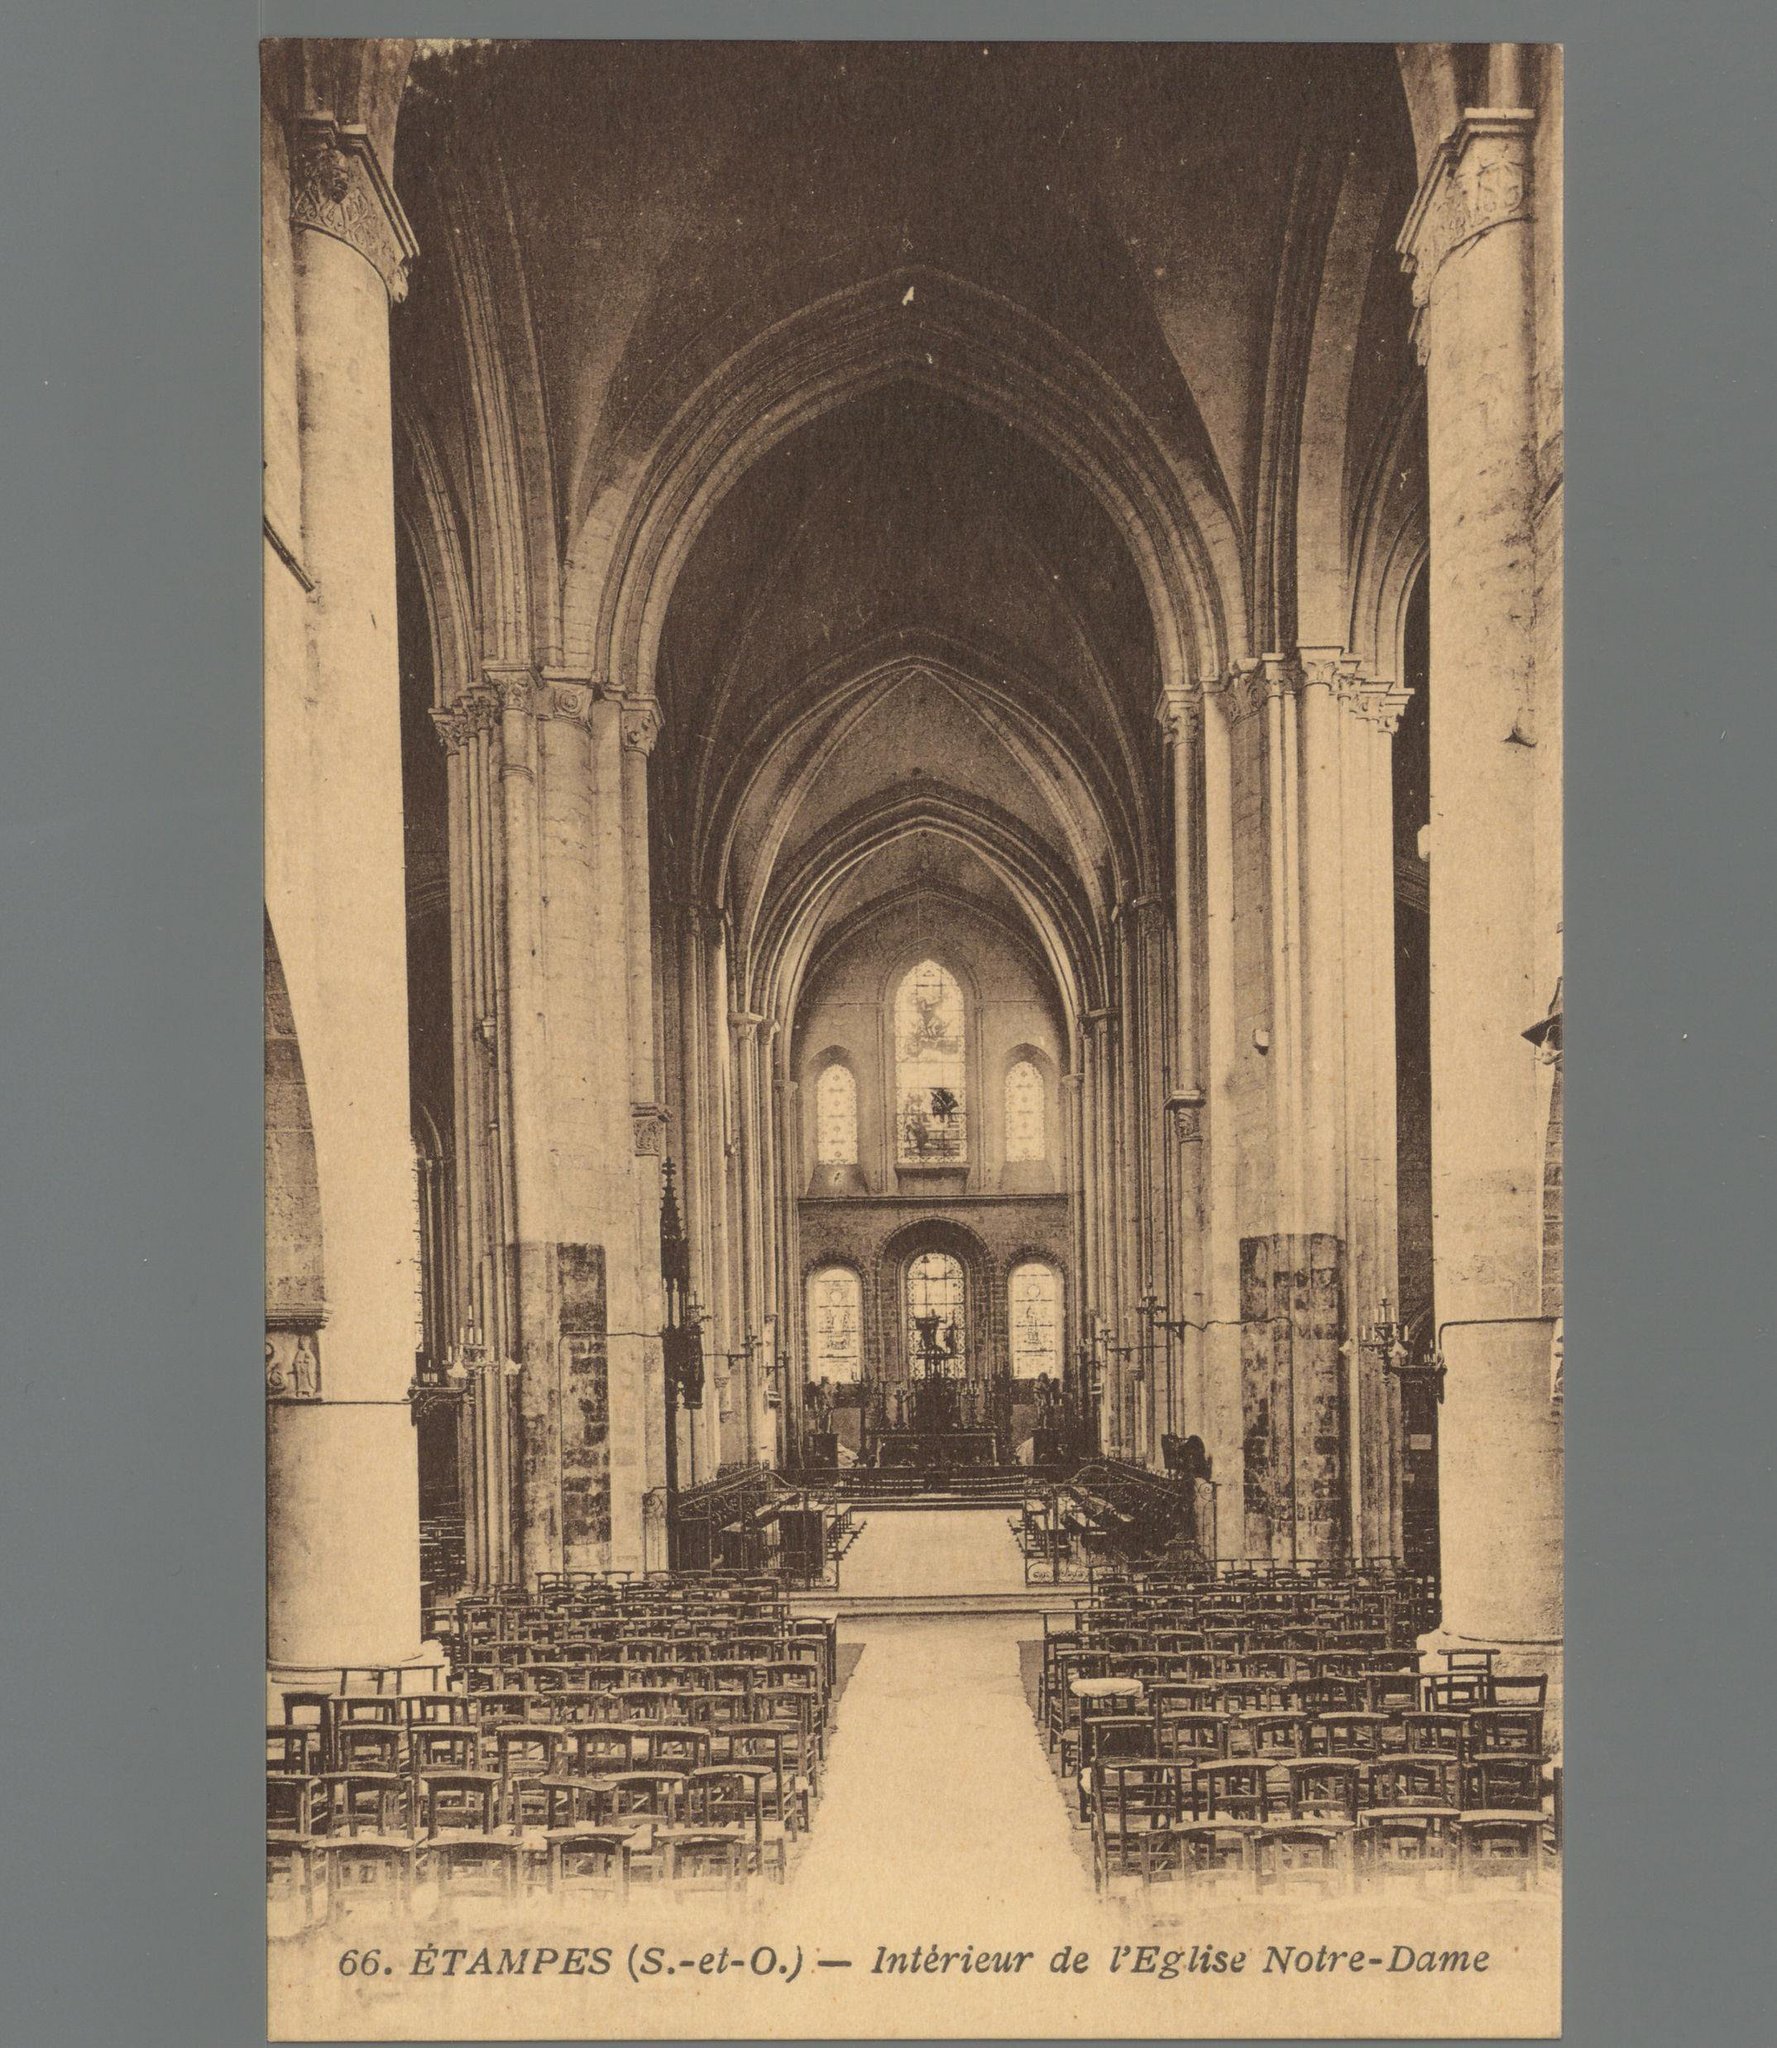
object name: photomechanical print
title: Étampes (S.-et-O.) - Intérieur de l'Eglise Notre-Dame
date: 1903-1930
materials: cardboard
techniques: photograph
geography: etampes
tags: interior of church